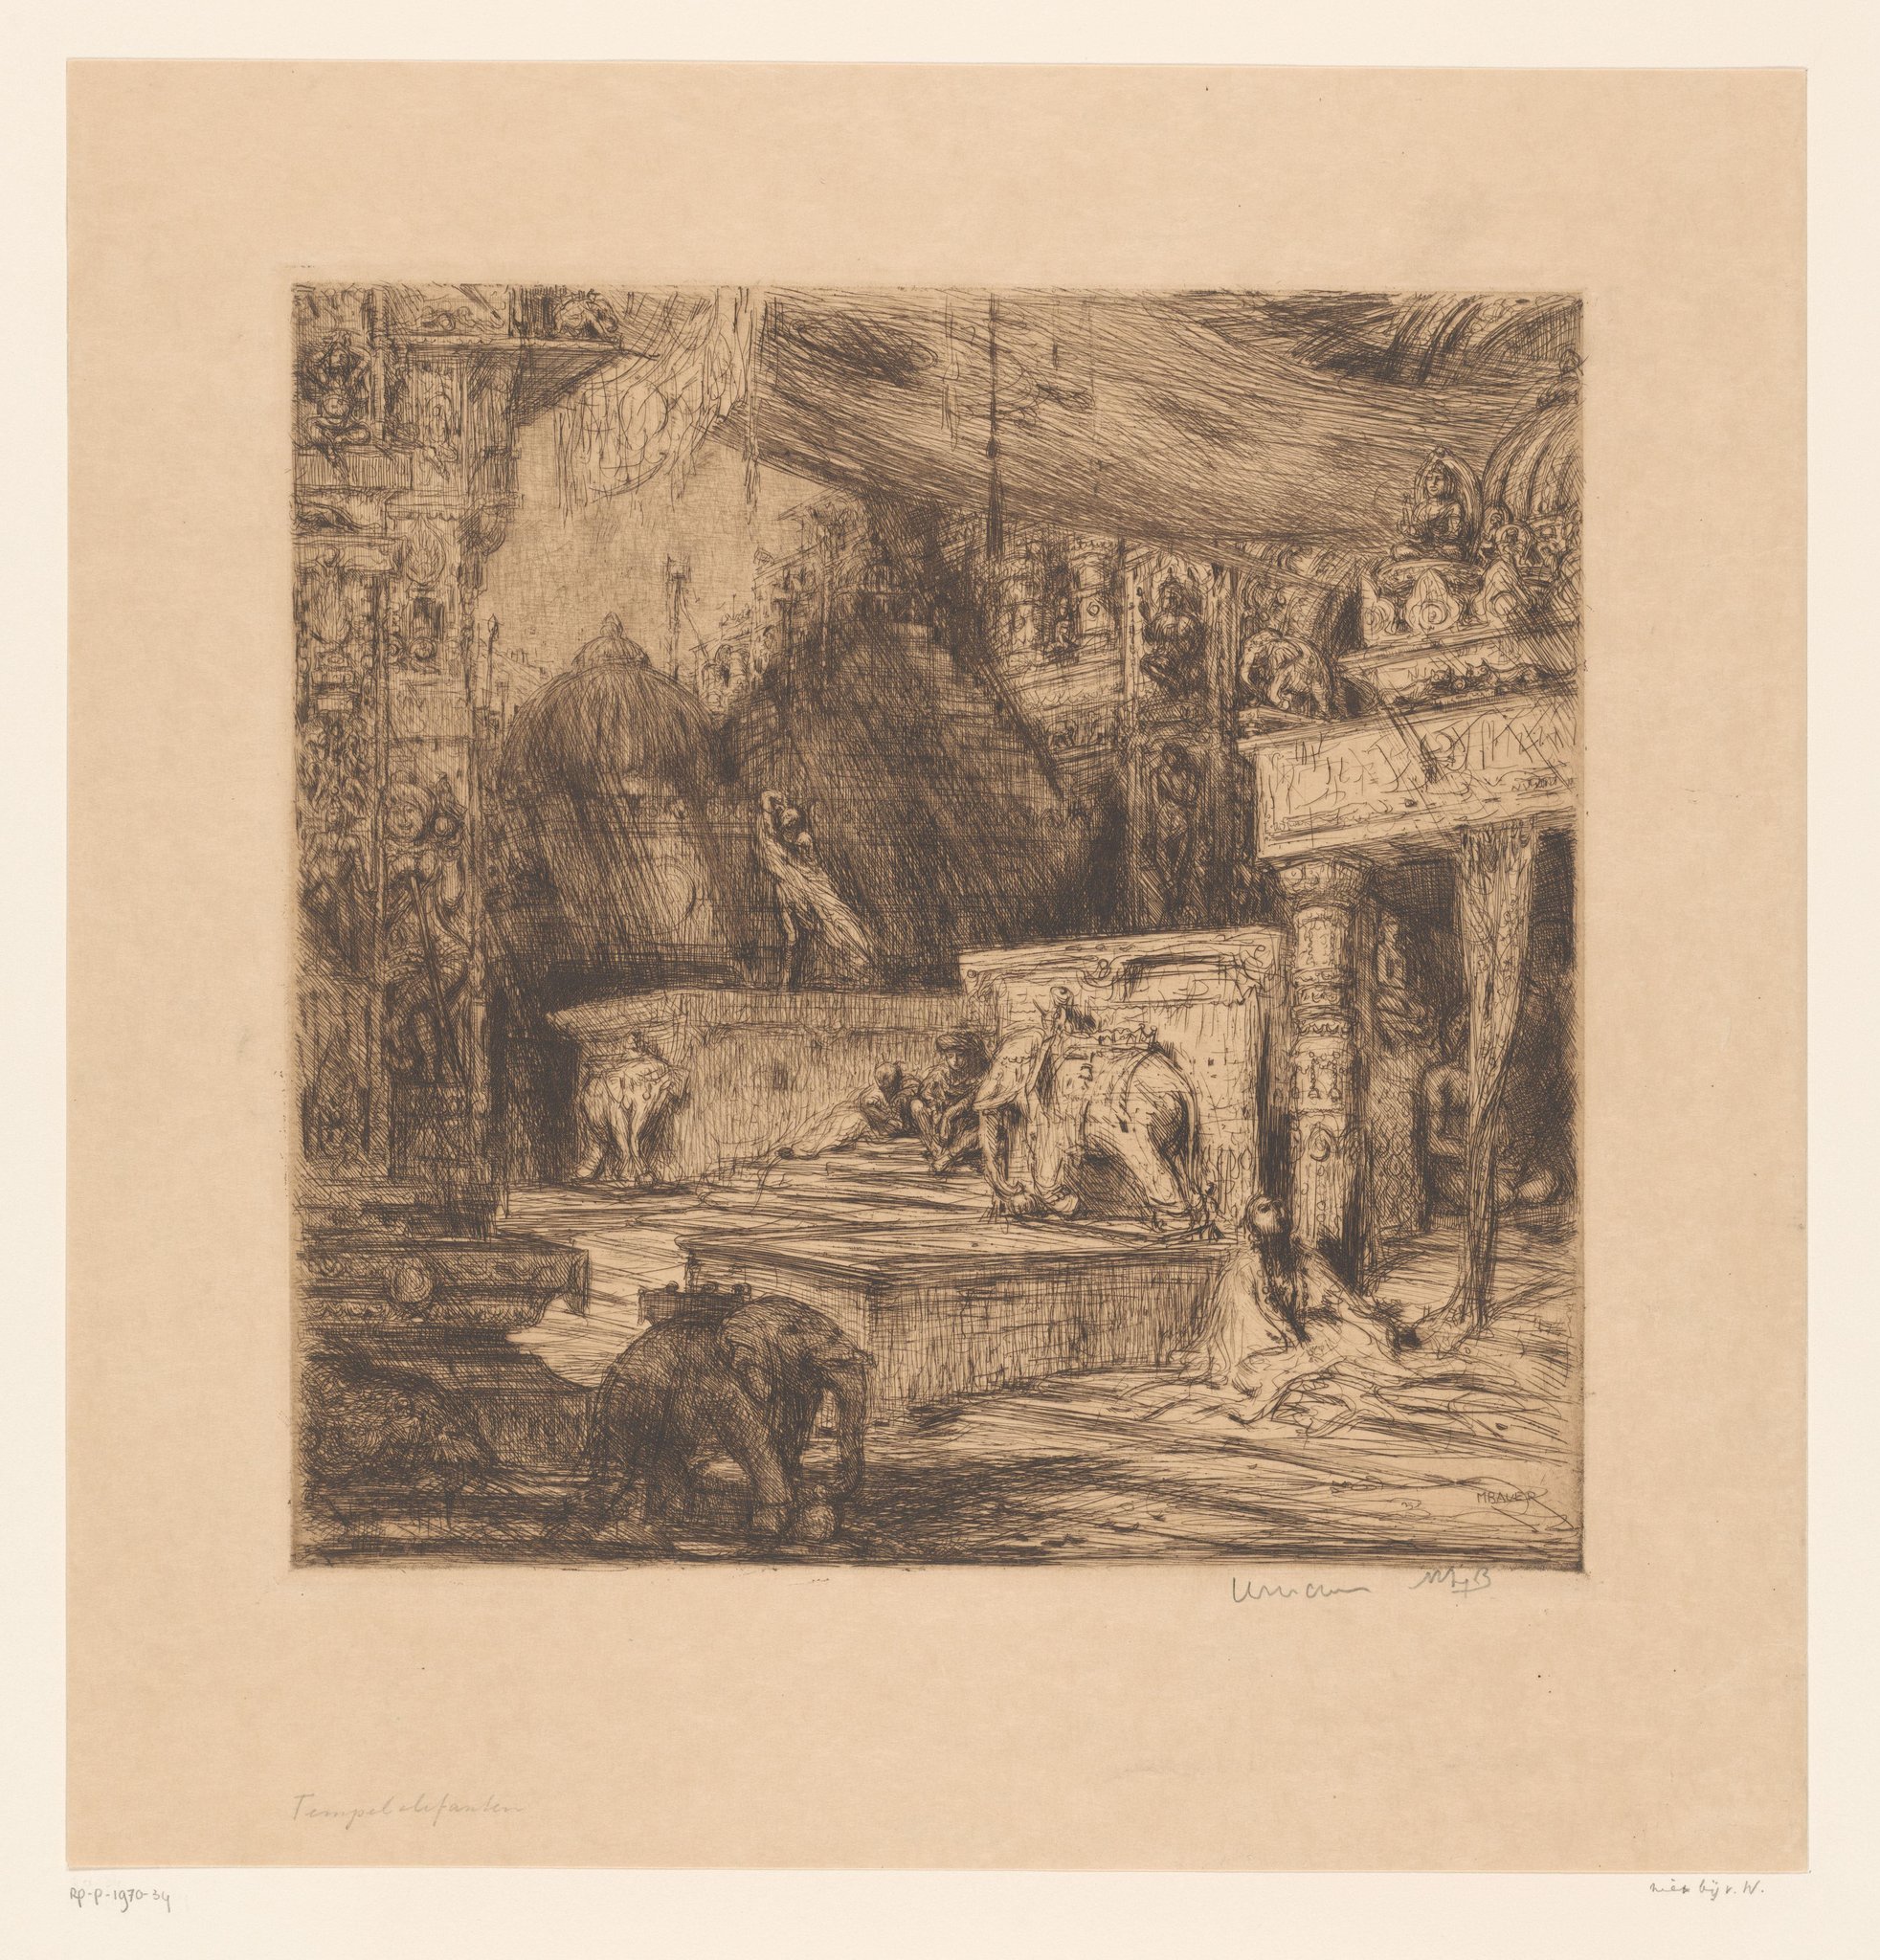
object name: print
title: Tempelolifanten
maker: marius bauer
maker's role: draughtsman, print maker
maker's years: 1867-1932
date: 1877-1932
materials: paper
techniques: etching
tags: sitting figure, non-christian religions (including institutions, customs and antiquities), trunked animals: elephant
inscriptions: inscription: ‘[...] MHB’, collector's mark: Lugt 2228, collector's mark: Lugt 2760